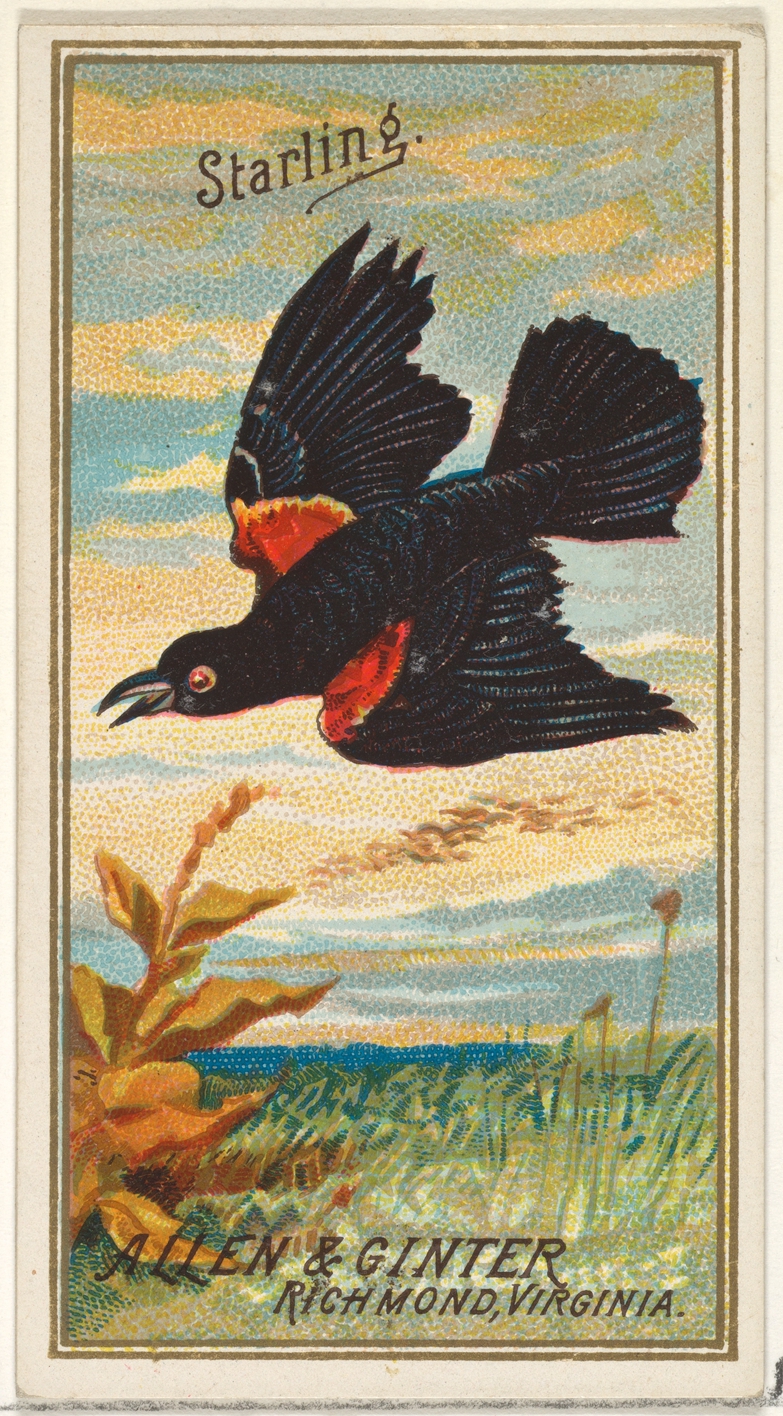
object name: print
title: Starling, from the Birds of America series (N4) for Allen & Ginter Cigarettes Brands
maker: allen & ginter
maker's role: publisher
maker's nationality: american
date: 1888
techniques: color lithograph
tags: birds